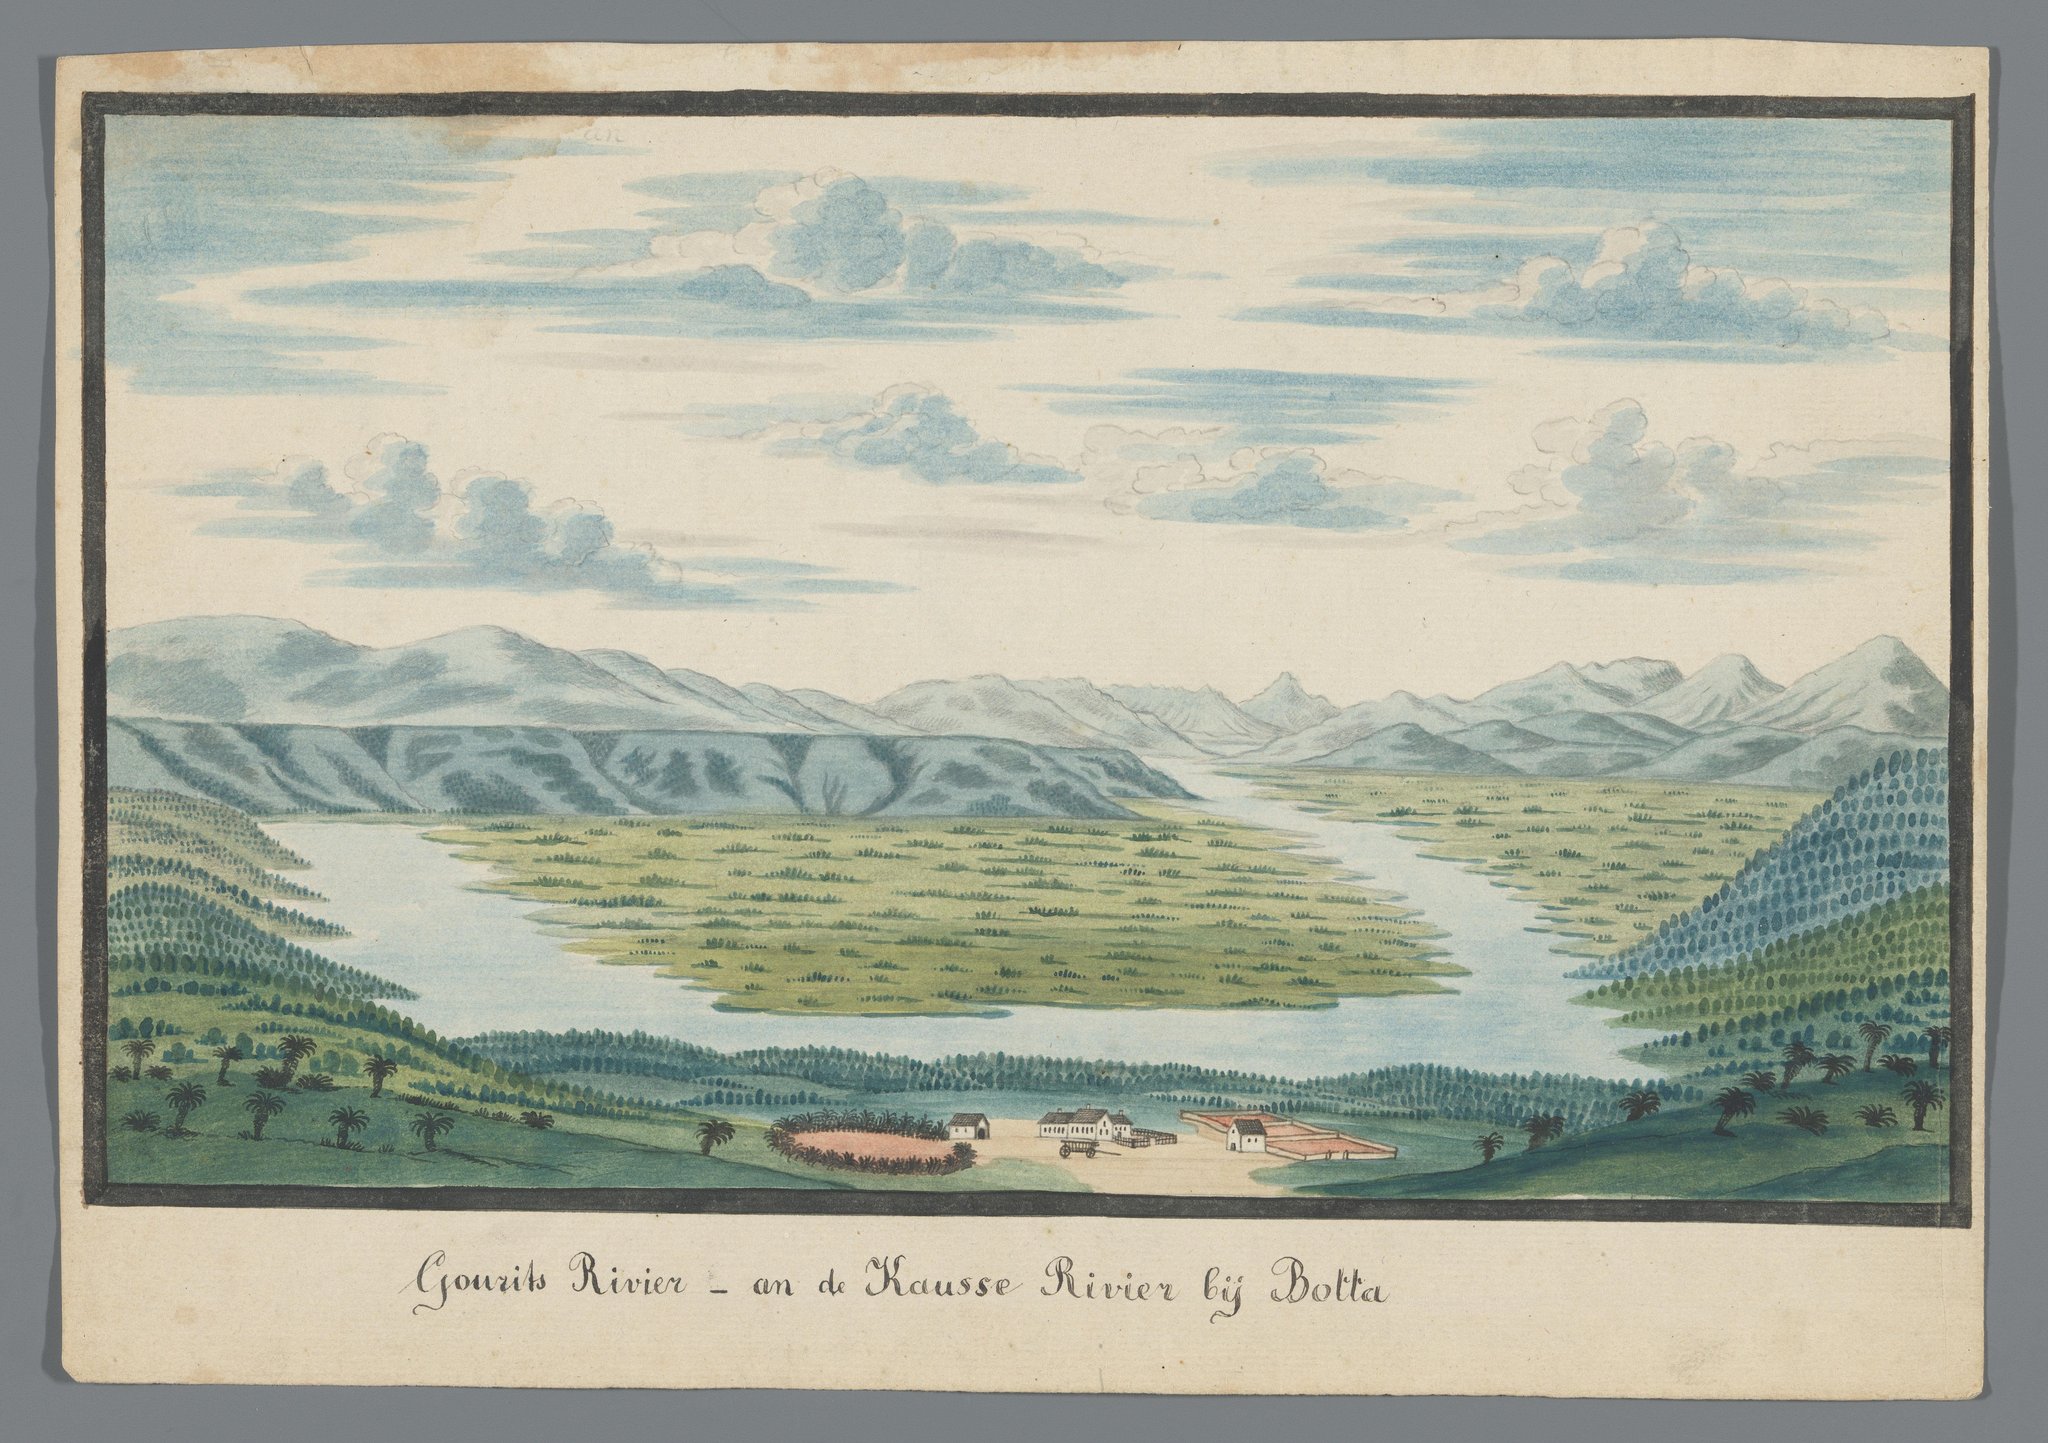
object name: drawing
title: De Gourtis Rivier bij Jacobus Botha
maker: johannes schumacher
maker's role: draughtsman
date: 1712-1776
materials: paper, watercolor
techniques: brush, pen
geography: south africa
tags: cape of good hope, river, mountain-range, snow peaks, farm or solitary house in landscape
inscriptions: label: ‘11’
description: Gezicht op de Gourits (Gaurits) Rivier en de boerderij van Jacobus Botha de Oude. Tekening gemaakt tijdens de tweede reis van Hendrik Swellengrebel, naar het noordoosten van de Kaapkolonie, 10 september - 26 december 1776. Volgens het reisjournaal wordt het gezelschap ontvangen op de plaats van Botha op 7 december 1776.